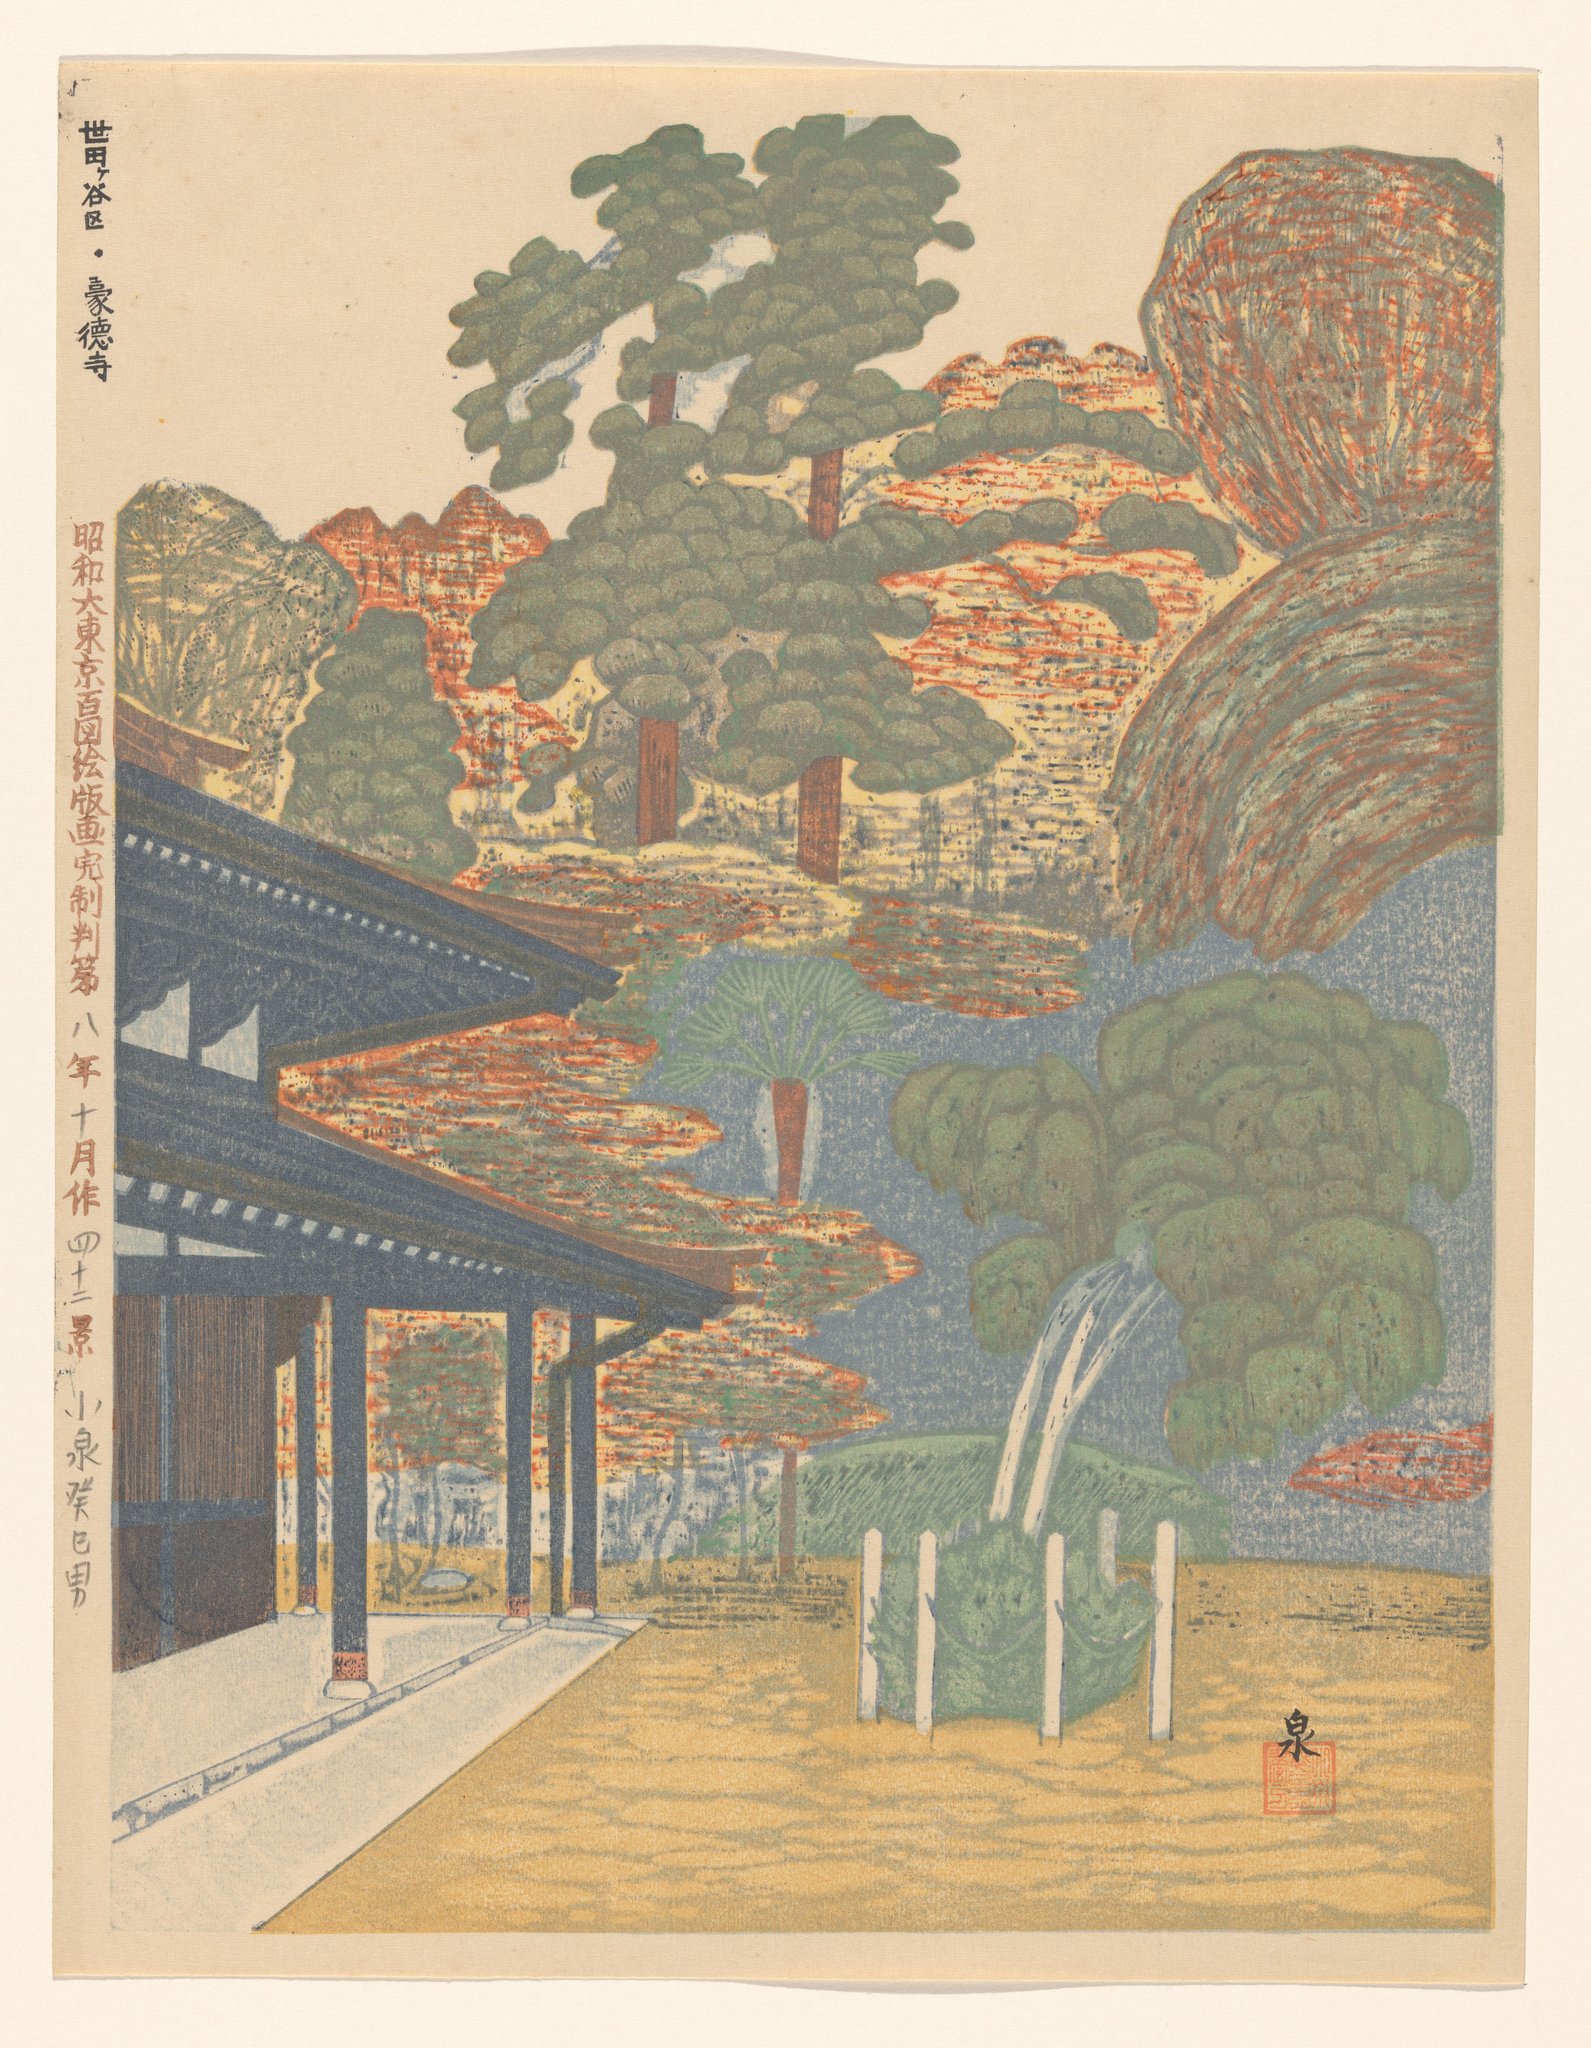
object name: print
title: Shōwa dai Tōkyō hyakuzue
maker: koizumi kishio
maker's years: 1893-1945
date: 1910-1933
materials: paper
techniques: woodcut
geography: japan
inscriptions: signature: ‘小泉癸巳男’, seal: ‘小泉癸巳男畫’, signature: ‘泉’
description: De achtergrond kleurt rood en geel van de herfstbladeren bij de Gōtoku-tempel in zuidwestelijk Tokyo. Links is een deel van de tempelhal zichtbaar. In september 1928 begon Koizumi Kishio aan zijn ambitieuze plan om honderd landschapsprenten met scènes in Tokyo volledig zelf te ontwerpen, hiervan zelf de drukblokken te snijden en zelf de prenten te drukken. De aanleiding voor het project was grote verandering die Tokyo onderging door de verwoestende Grote Kantō-aardbeving van 1923 en de wederopbouw die daarop volgde. Kishio maakt een bewuste verwijzing naar de bekende serie ‘Honderd beroemde gezichten op Edo’ door Utagawa Hiroshige (1797–1858), met prenten van locaties in Edo—de oude benaming voor Tokyo. Kishio toont overwegend moderne gebouwen, instituten en mensen die de tijdsgeest van de jaren 1920 en 1930 weerspiegelen. Sommige prenten onthullen daarentegen een nostalgische blik op overblijfselen uit het oude Edo. Kishio verkocht de prenten aan de hand van een abonnement met een limiet van vijftig leden, die elke maand een of twee prenten zouden ontvangen. Het project begon met negen abonnementen, maar al na de tweede maand werden meerdere daarvan opgezegd en slechts vier mecenassen bleven lid tot en met de voltooiing van de serie. Hij bracht het honderdste ontwerp uit in 1937. Zijn leermeester Ishii Hakutei schreef een inleiding in 1938 die Kishio verwerkte tot een prent en toevoegde aan de set. Tussen 1939 en 1940 maakte hij nog eens negen extra ontwerpen. Met acht van deze ontwerpen verving hij oudere nummers uit de serie, mogelijk omdat hij niet tevreden was met de composities. Uiteindelijk lukte het Kishio om tien complete sets te verkopen aan de shin hanga-uitgever Watanabe Shōzaburō en liet hiervoor speciale houten dozen maken. Deze prent behoort tot een van die tien sets.